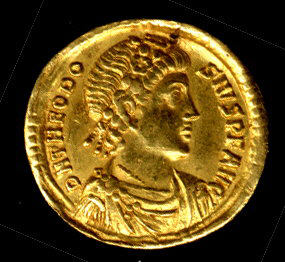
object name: solidus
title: Gold Solidus of Theodosius I (379–95)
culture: byzantine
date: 379-395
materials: gold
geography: constantinople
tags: profiles,coins